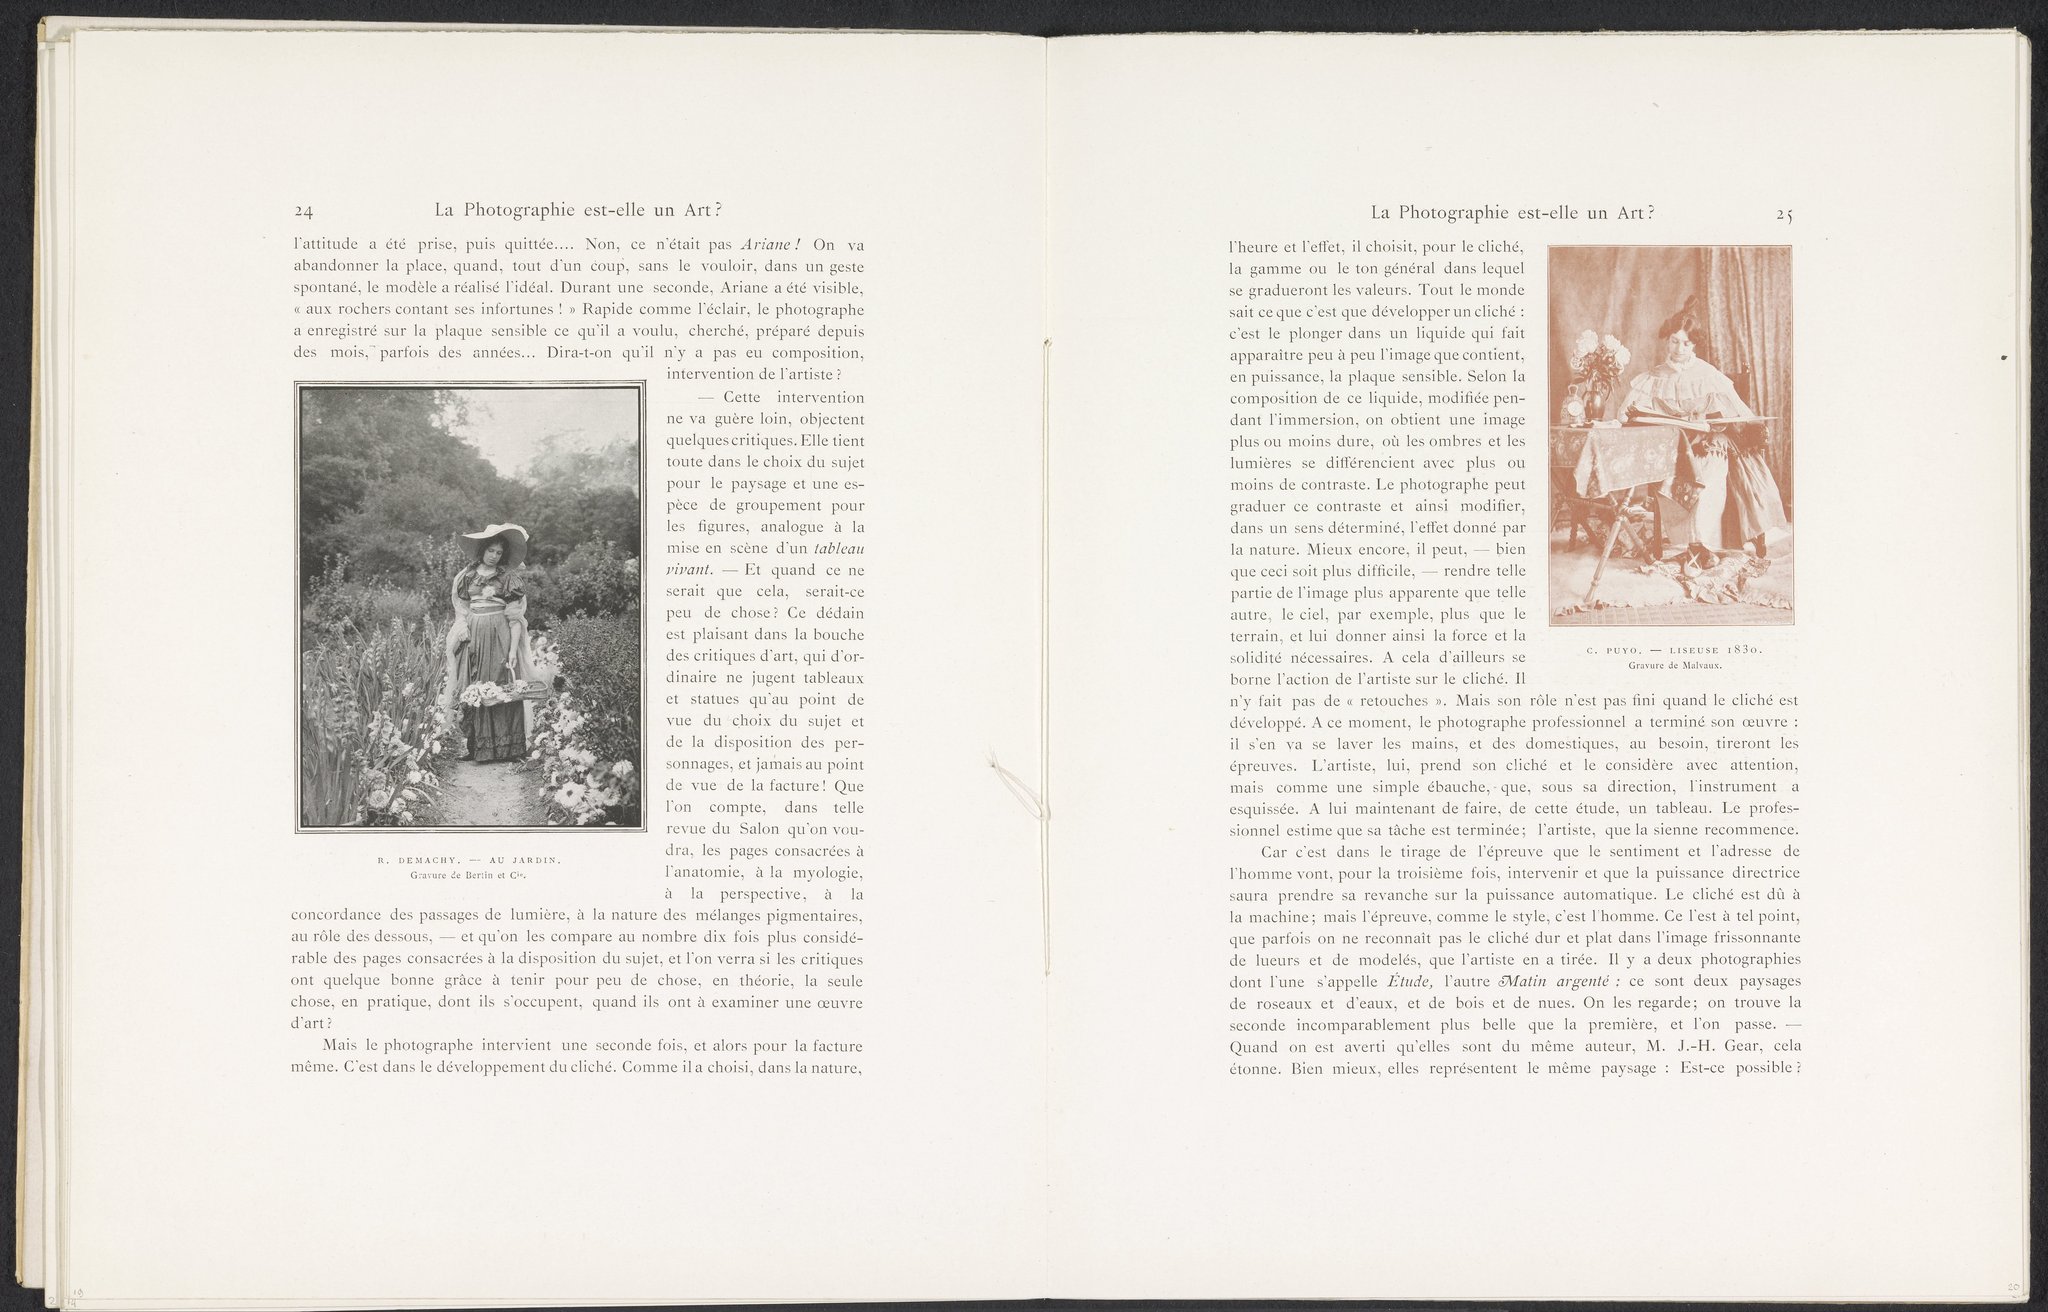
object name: photomechanical print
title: Vrouw met een bloemenmand in een tuin met bloemen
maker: robert demachy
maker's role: fotograaf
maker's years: 1859-1936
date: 1889-1899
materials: paper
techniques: autotype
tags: picking flowers